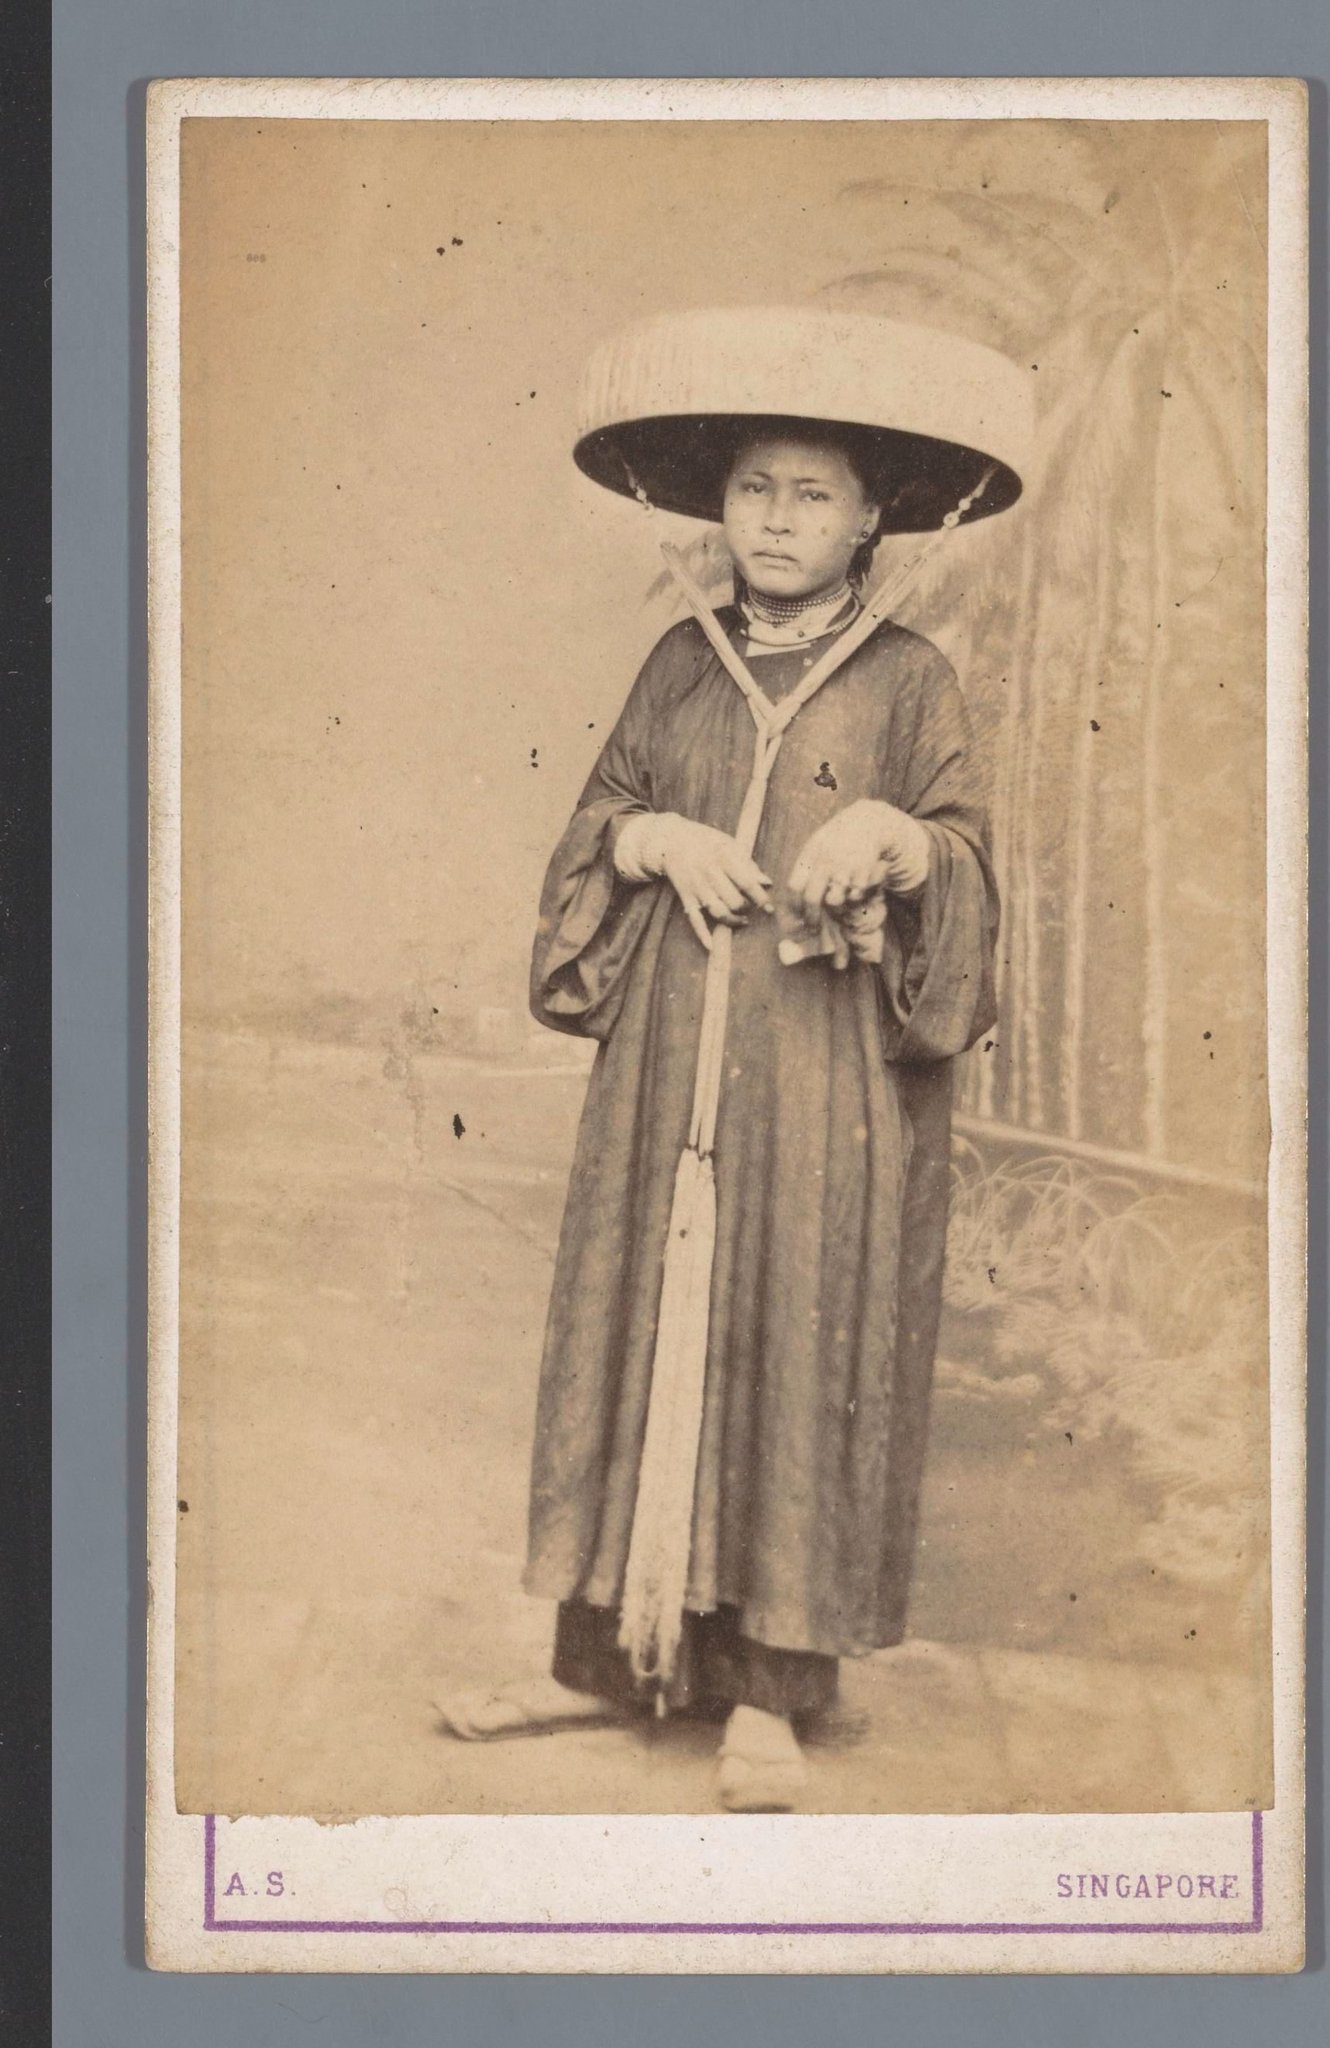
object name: photograph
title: China meid Saigon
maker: august sachtler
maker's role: fotograaf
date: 1870-1900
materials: cardboard, paper, photographic support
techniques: albumen print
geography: singapore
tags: historical persons not known by name - bb - woman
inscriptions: signature: ‘A. Sachtler photographer Singapore’, title: ‘China meid Saigon’, signature: ‘A.S. Singapore’